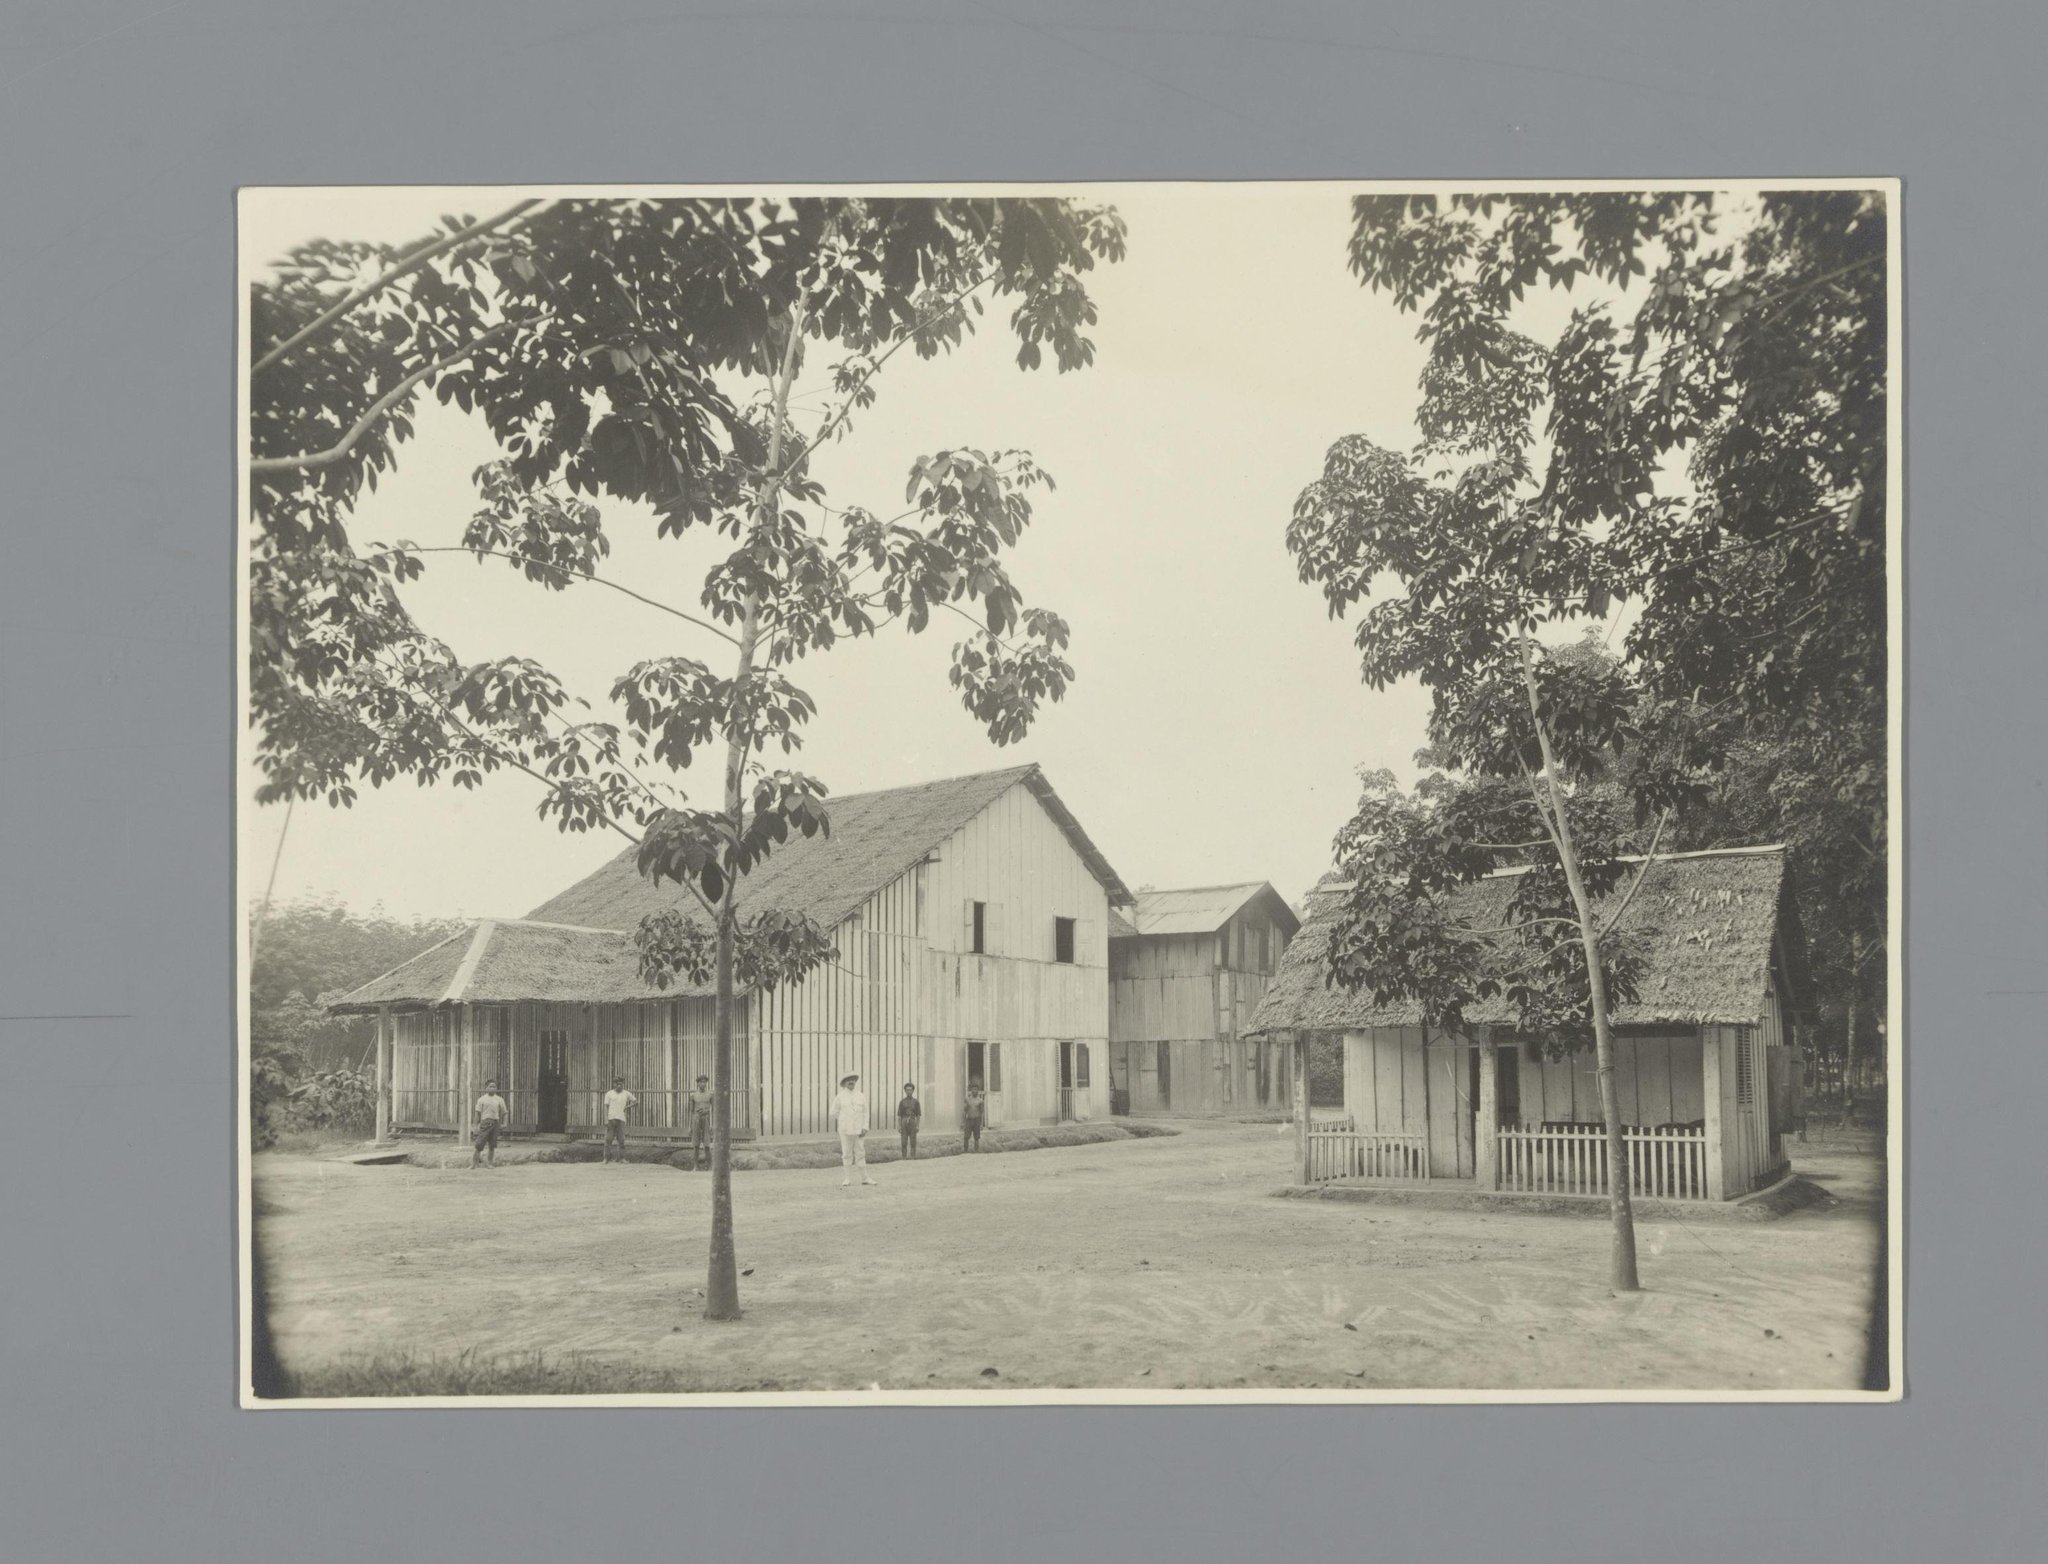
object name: photograph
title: Lokale arbeiders en een Europeaan voor gebouwen op de plantage van Paul Sandel, Sumatra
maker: Anonymous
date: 1920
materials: paper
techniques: gelatin silver print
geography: tandjong poera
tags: plantation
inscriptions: inscription: ‘26./ so sah zu meiner Zeit/ fabrik Rookluis/ aus/ 1920/ 23.’